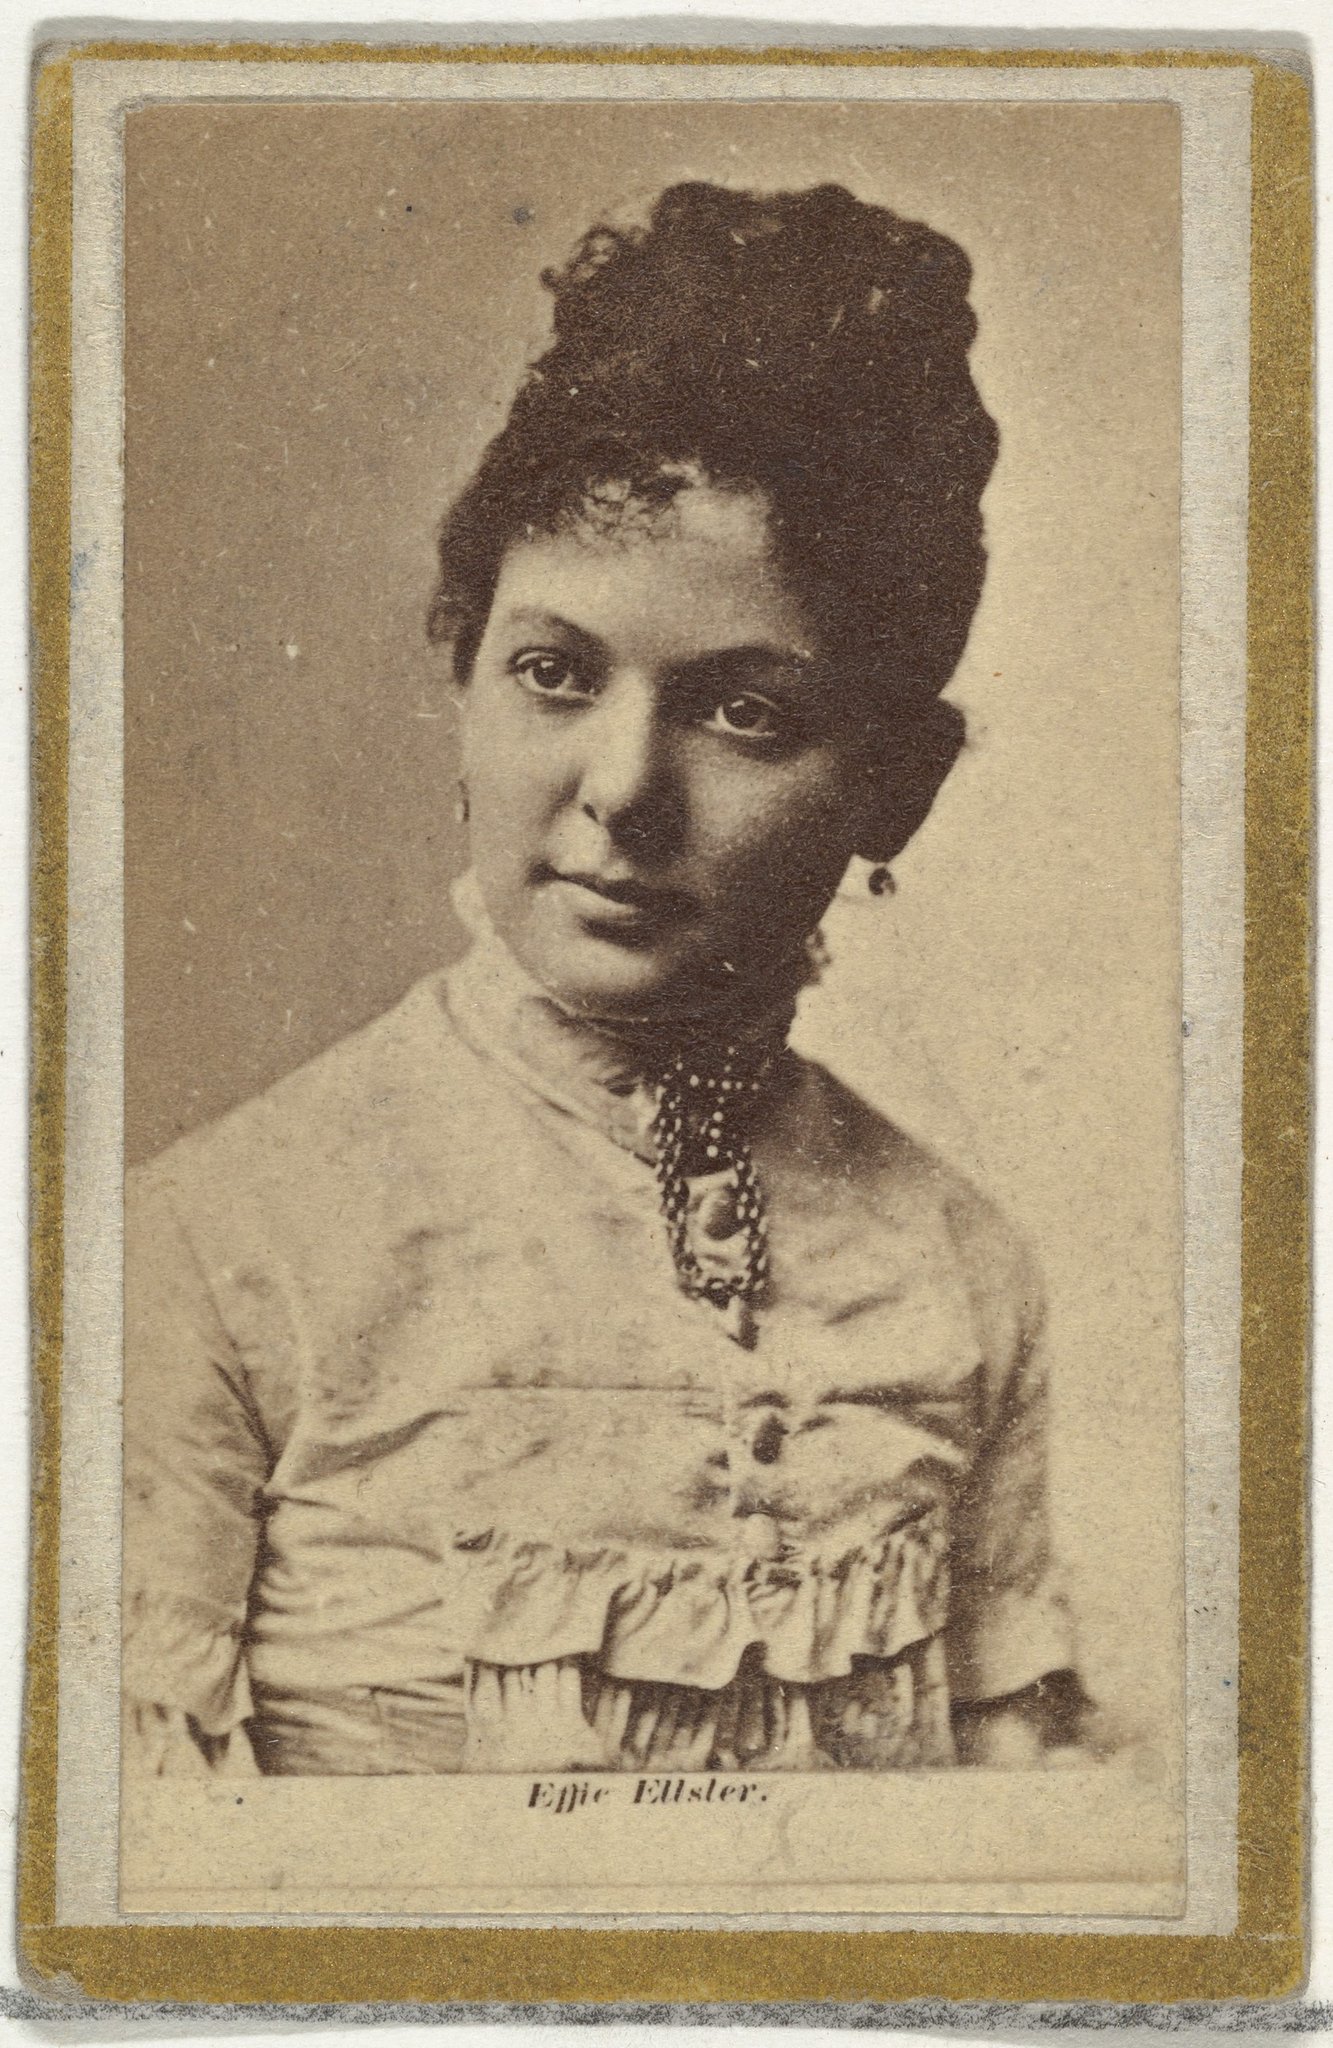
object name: photograph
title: Effie Ellster, from the Actresses and Celebrities series (N60, Type 2) promoting Little Beauties Cigarettes for Allen & Ginter brand tobacco products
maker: allen & ginter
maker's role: publisher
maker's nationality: american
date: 1887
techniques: albumen silver print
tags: portraits,women,actresses